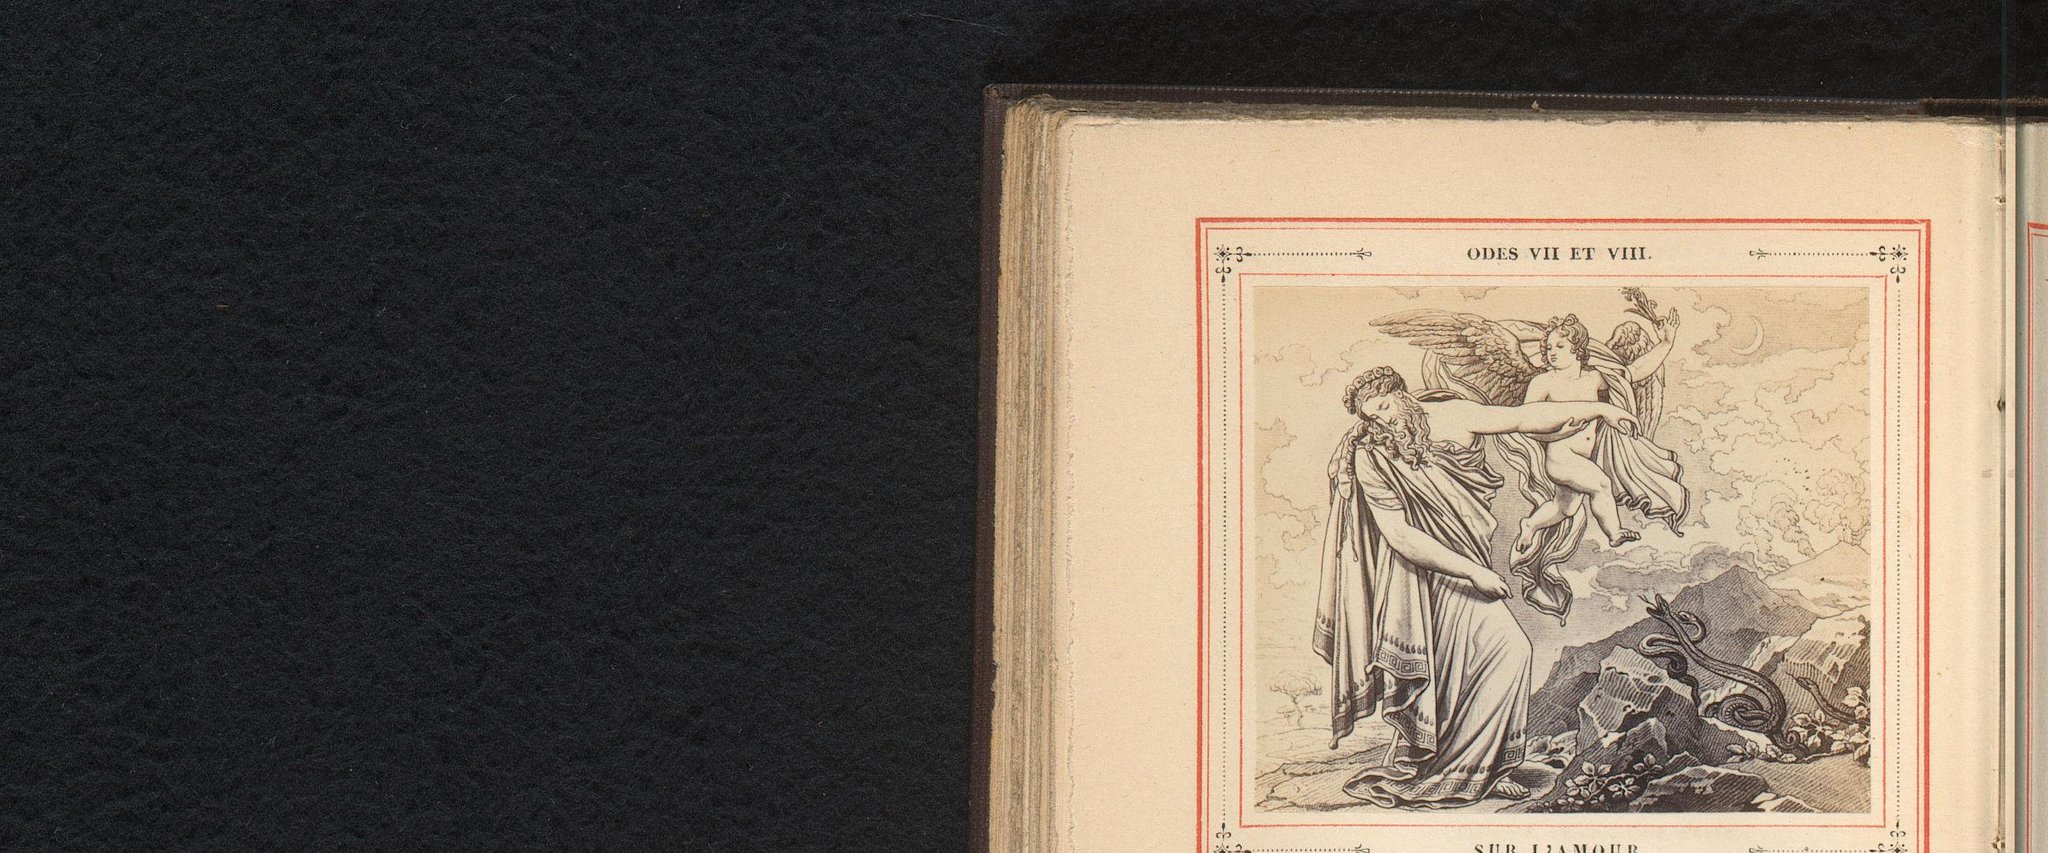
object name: photograph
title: Sur l'amour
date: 1859-1864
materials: paper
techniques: albumen print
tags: gods ~ classical mythology